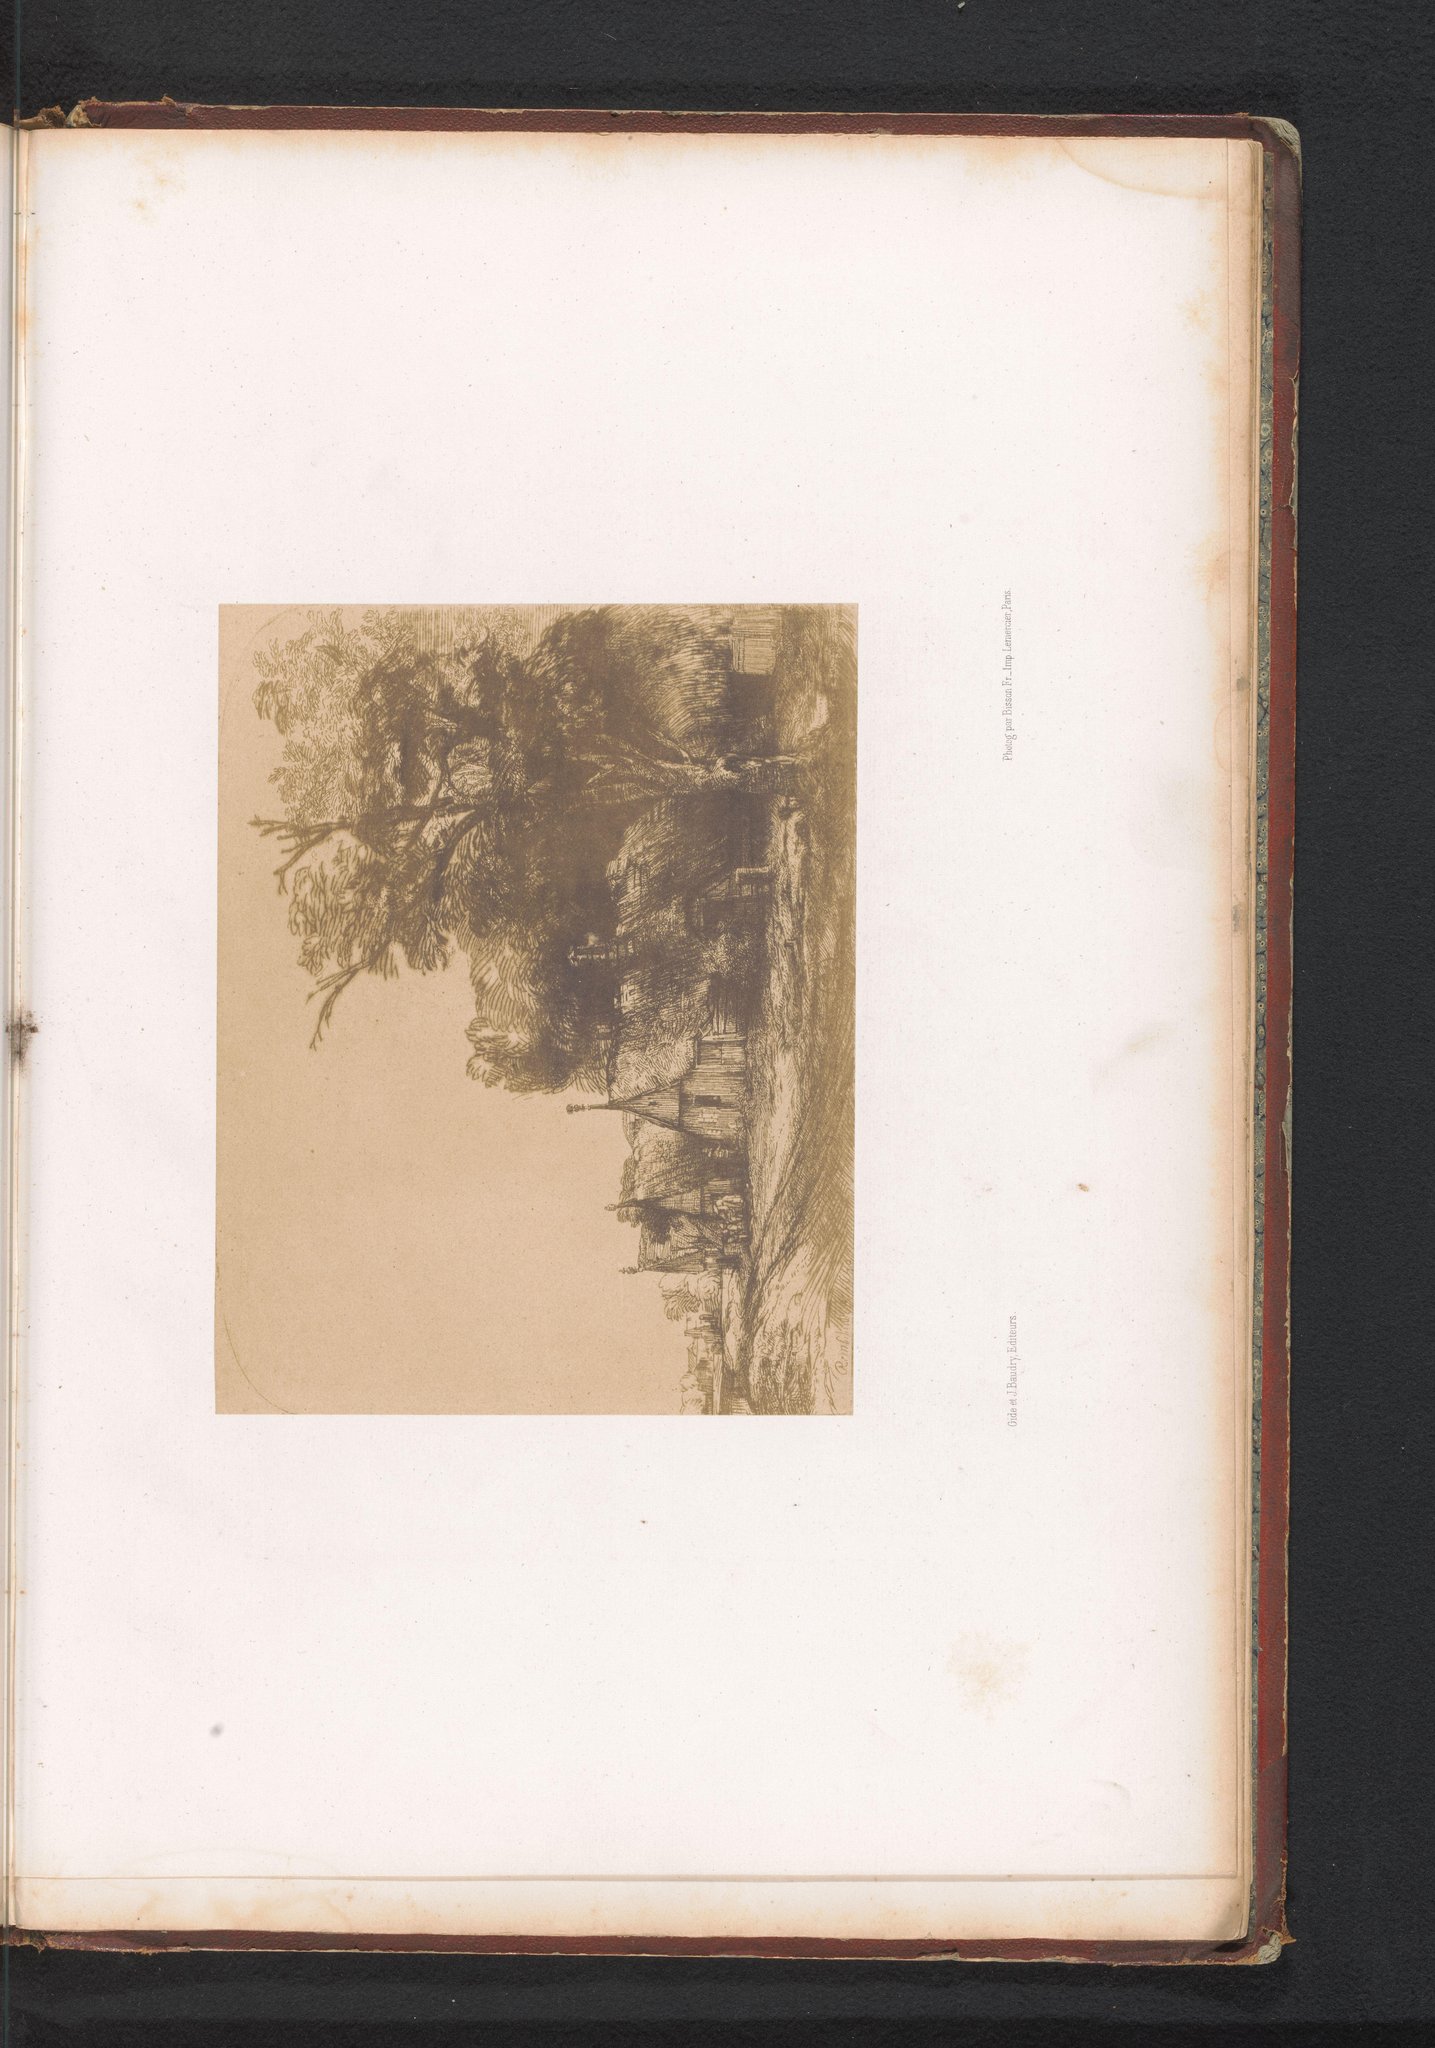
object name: page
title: Fotoreproductie van een ets van een landschap met drie boerderijen langs een weg door Rembrandt van Rijn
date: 1848-1853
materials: photographic support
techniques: salted paper print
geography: paris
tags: road, path, farm or solitary house in landscape